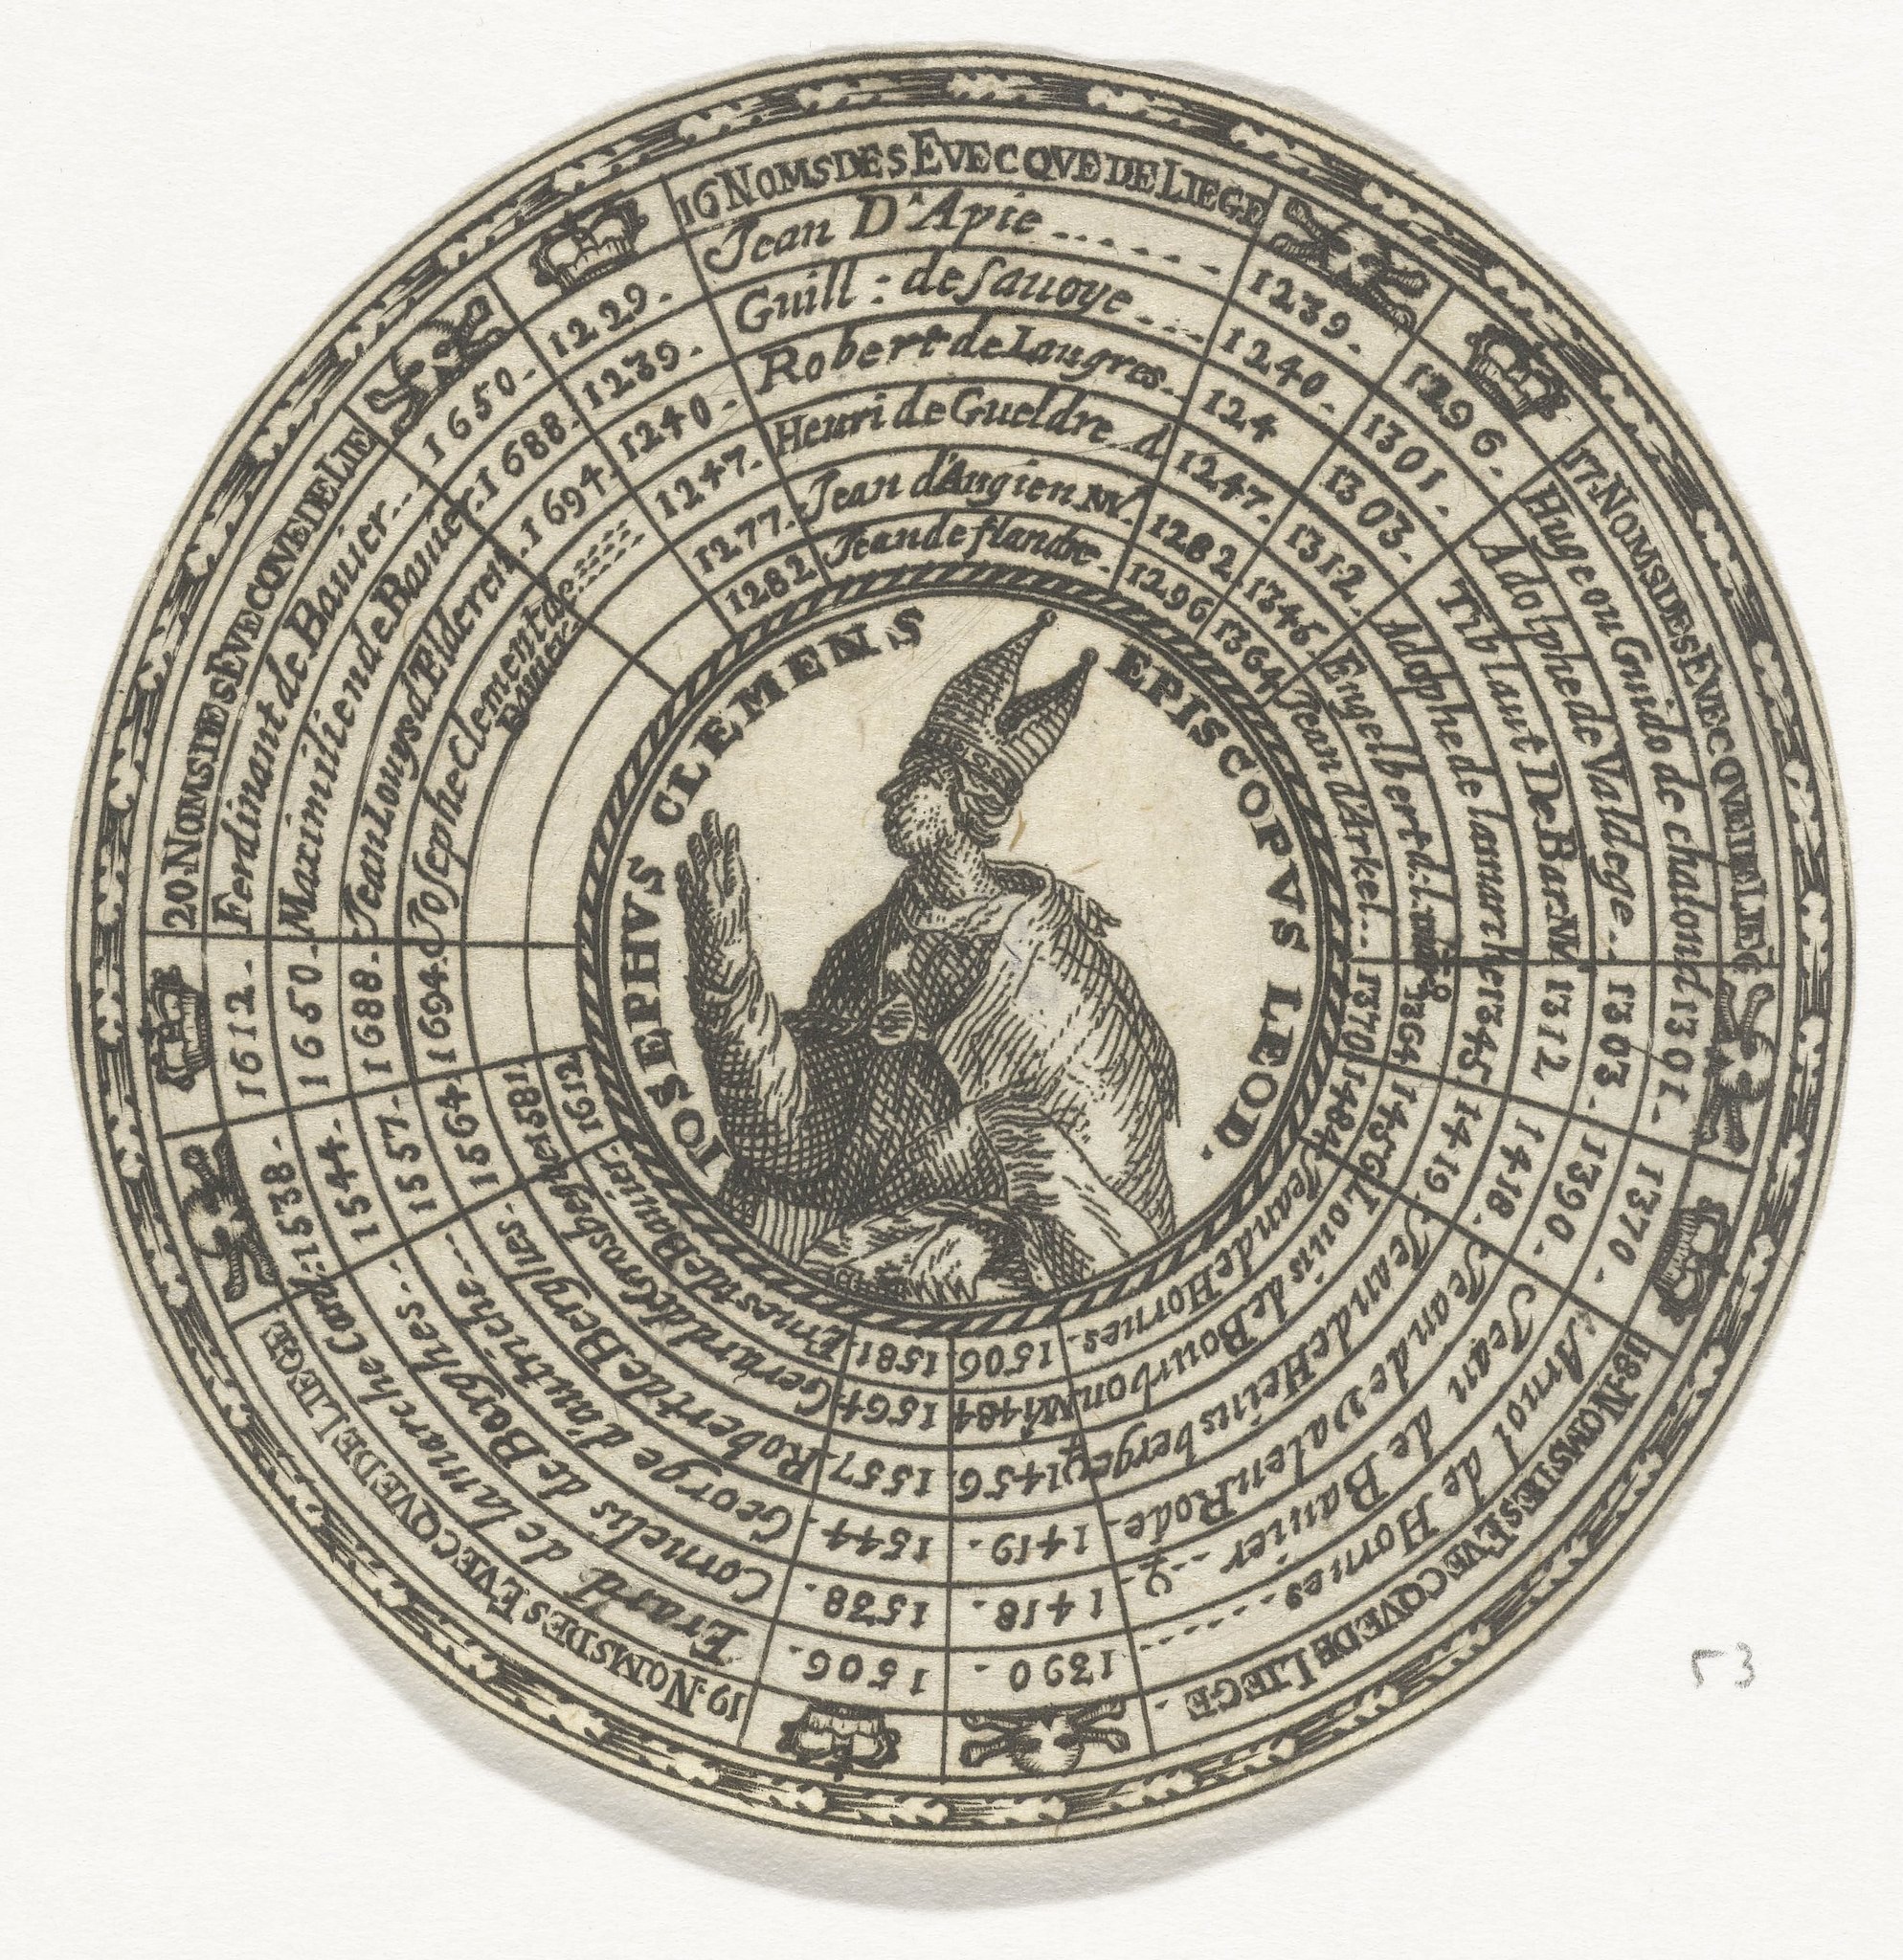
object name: print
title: Penning met het portret van bisschop Jozef Klemens en de namen van de bisschoppen van Luik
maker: Anonymous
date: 1685-1720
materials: paper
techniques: etching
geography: amsterdam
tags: priest, archbishop, bishop, etc. (roman catholic), seal (symbol of sovereignty)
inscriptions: number: ‘56’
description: Ontwerp van een ronde penning met, in zeven concentrische cirkels, de namen van de bisschoppen van Luik en hun regeringsjaren, beginnende bij bisschop Johan II en eindigend bij bisschop Jozef Klemens. In het midden van de penning het portret van bisschop Jozef Klemens van Beieren.